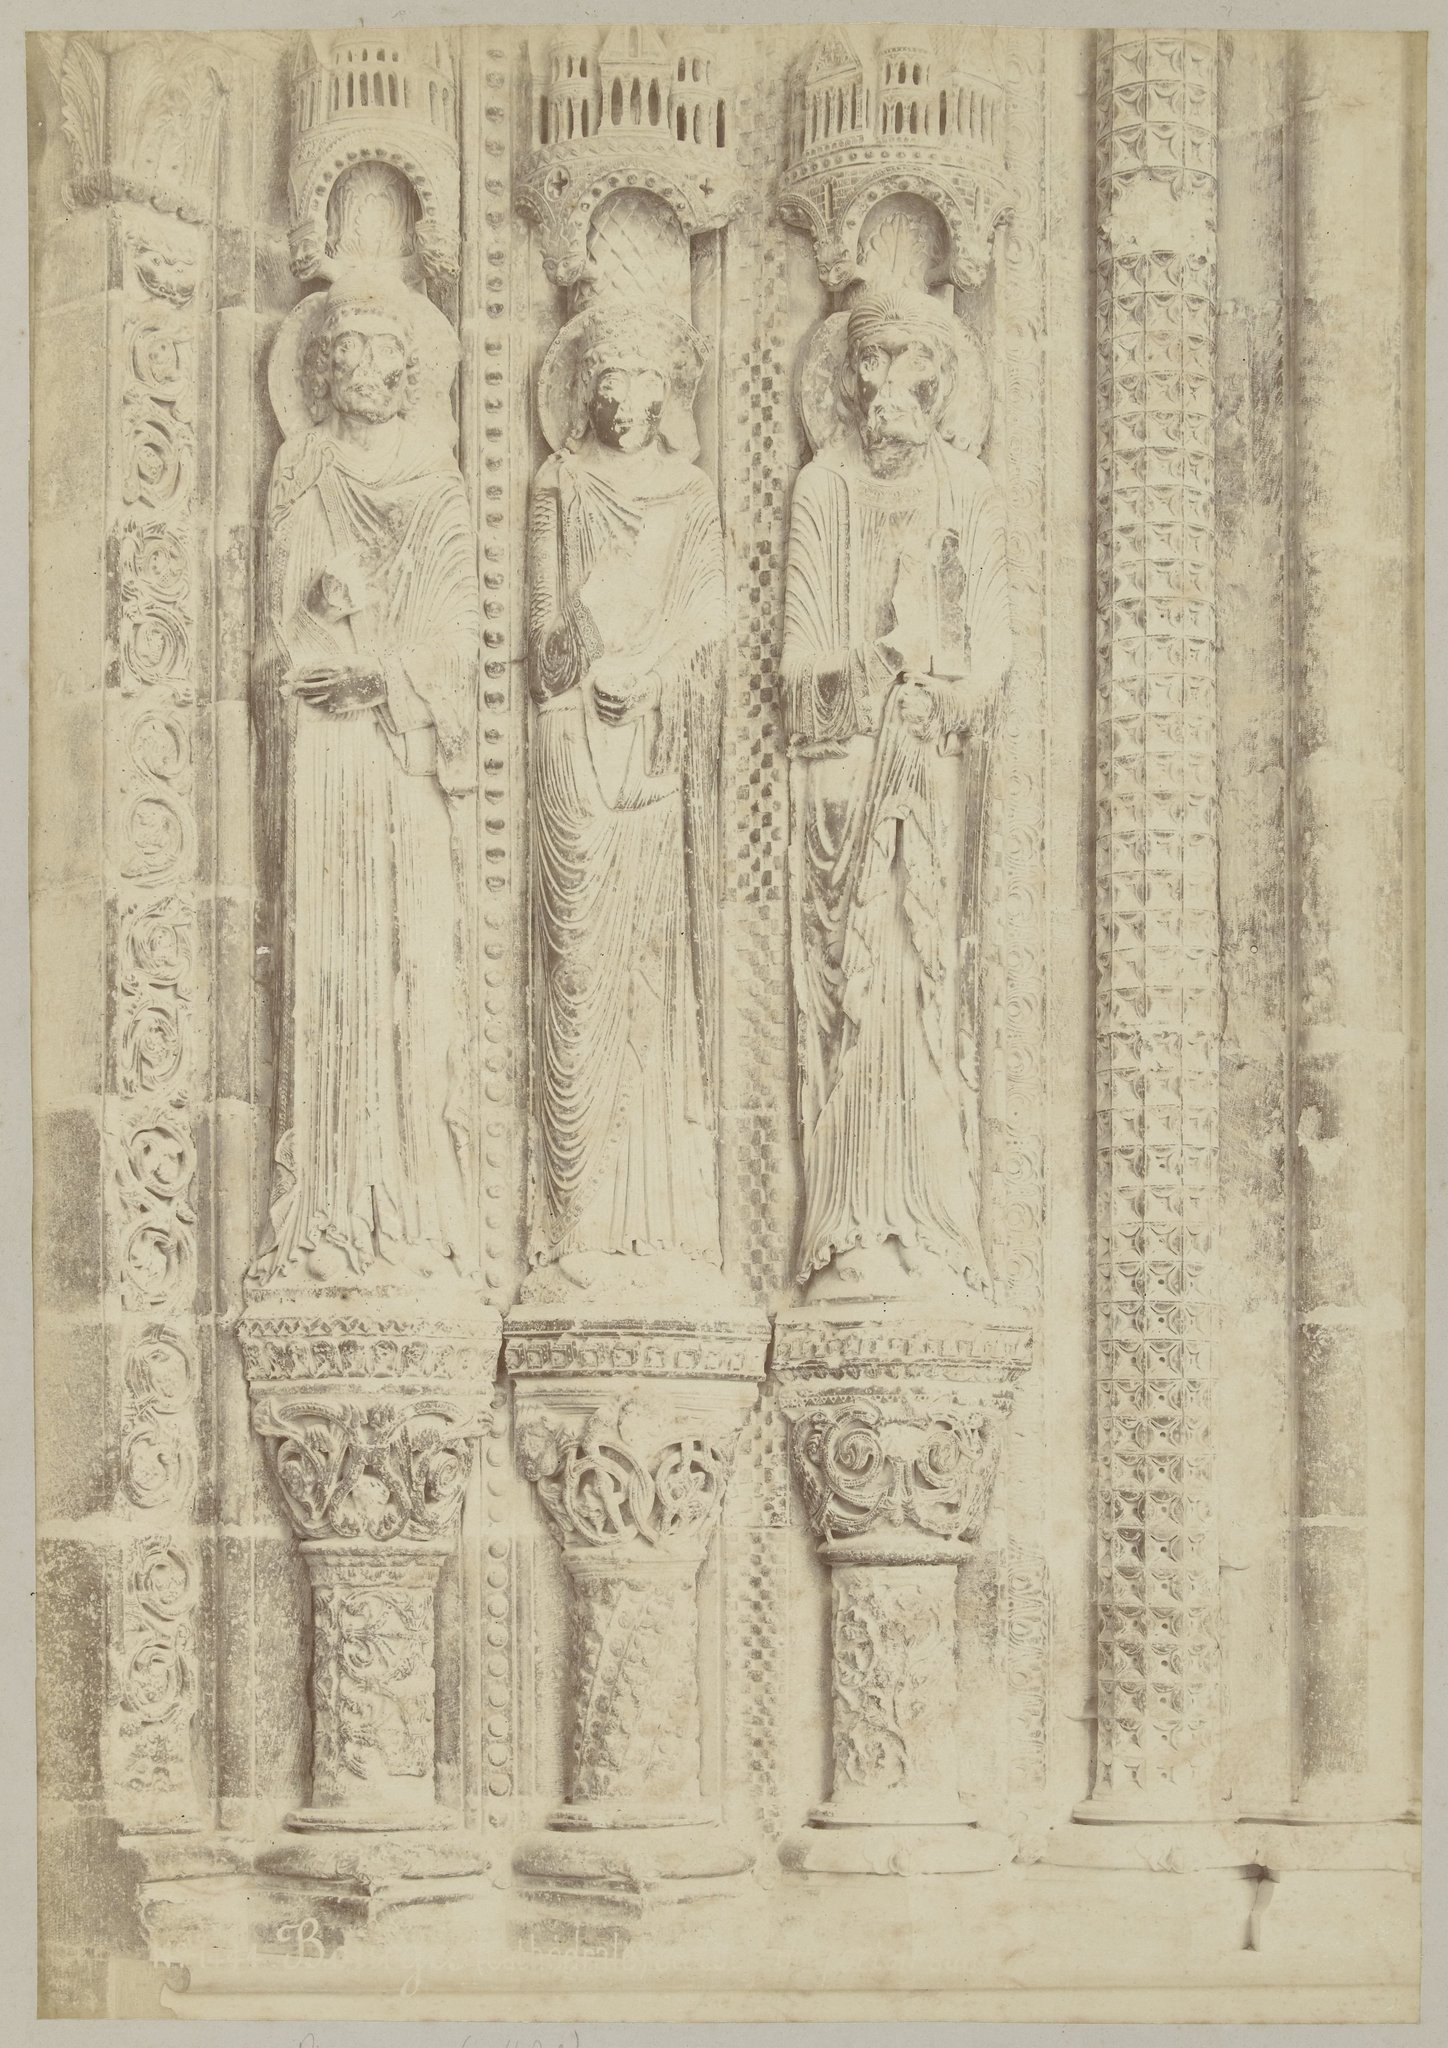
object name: photograph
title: Bourges (Cathédrale)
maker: paul robert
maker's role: fotograaf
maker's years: 1865-1905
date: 1890-1900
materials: cardboard, paper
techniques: albumen print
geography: bourges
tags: piece of sculpture, reproduction of a piece of sculpture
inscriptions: number: ‘No 1444’, inscription: ‘Bourges (cattedrale)’